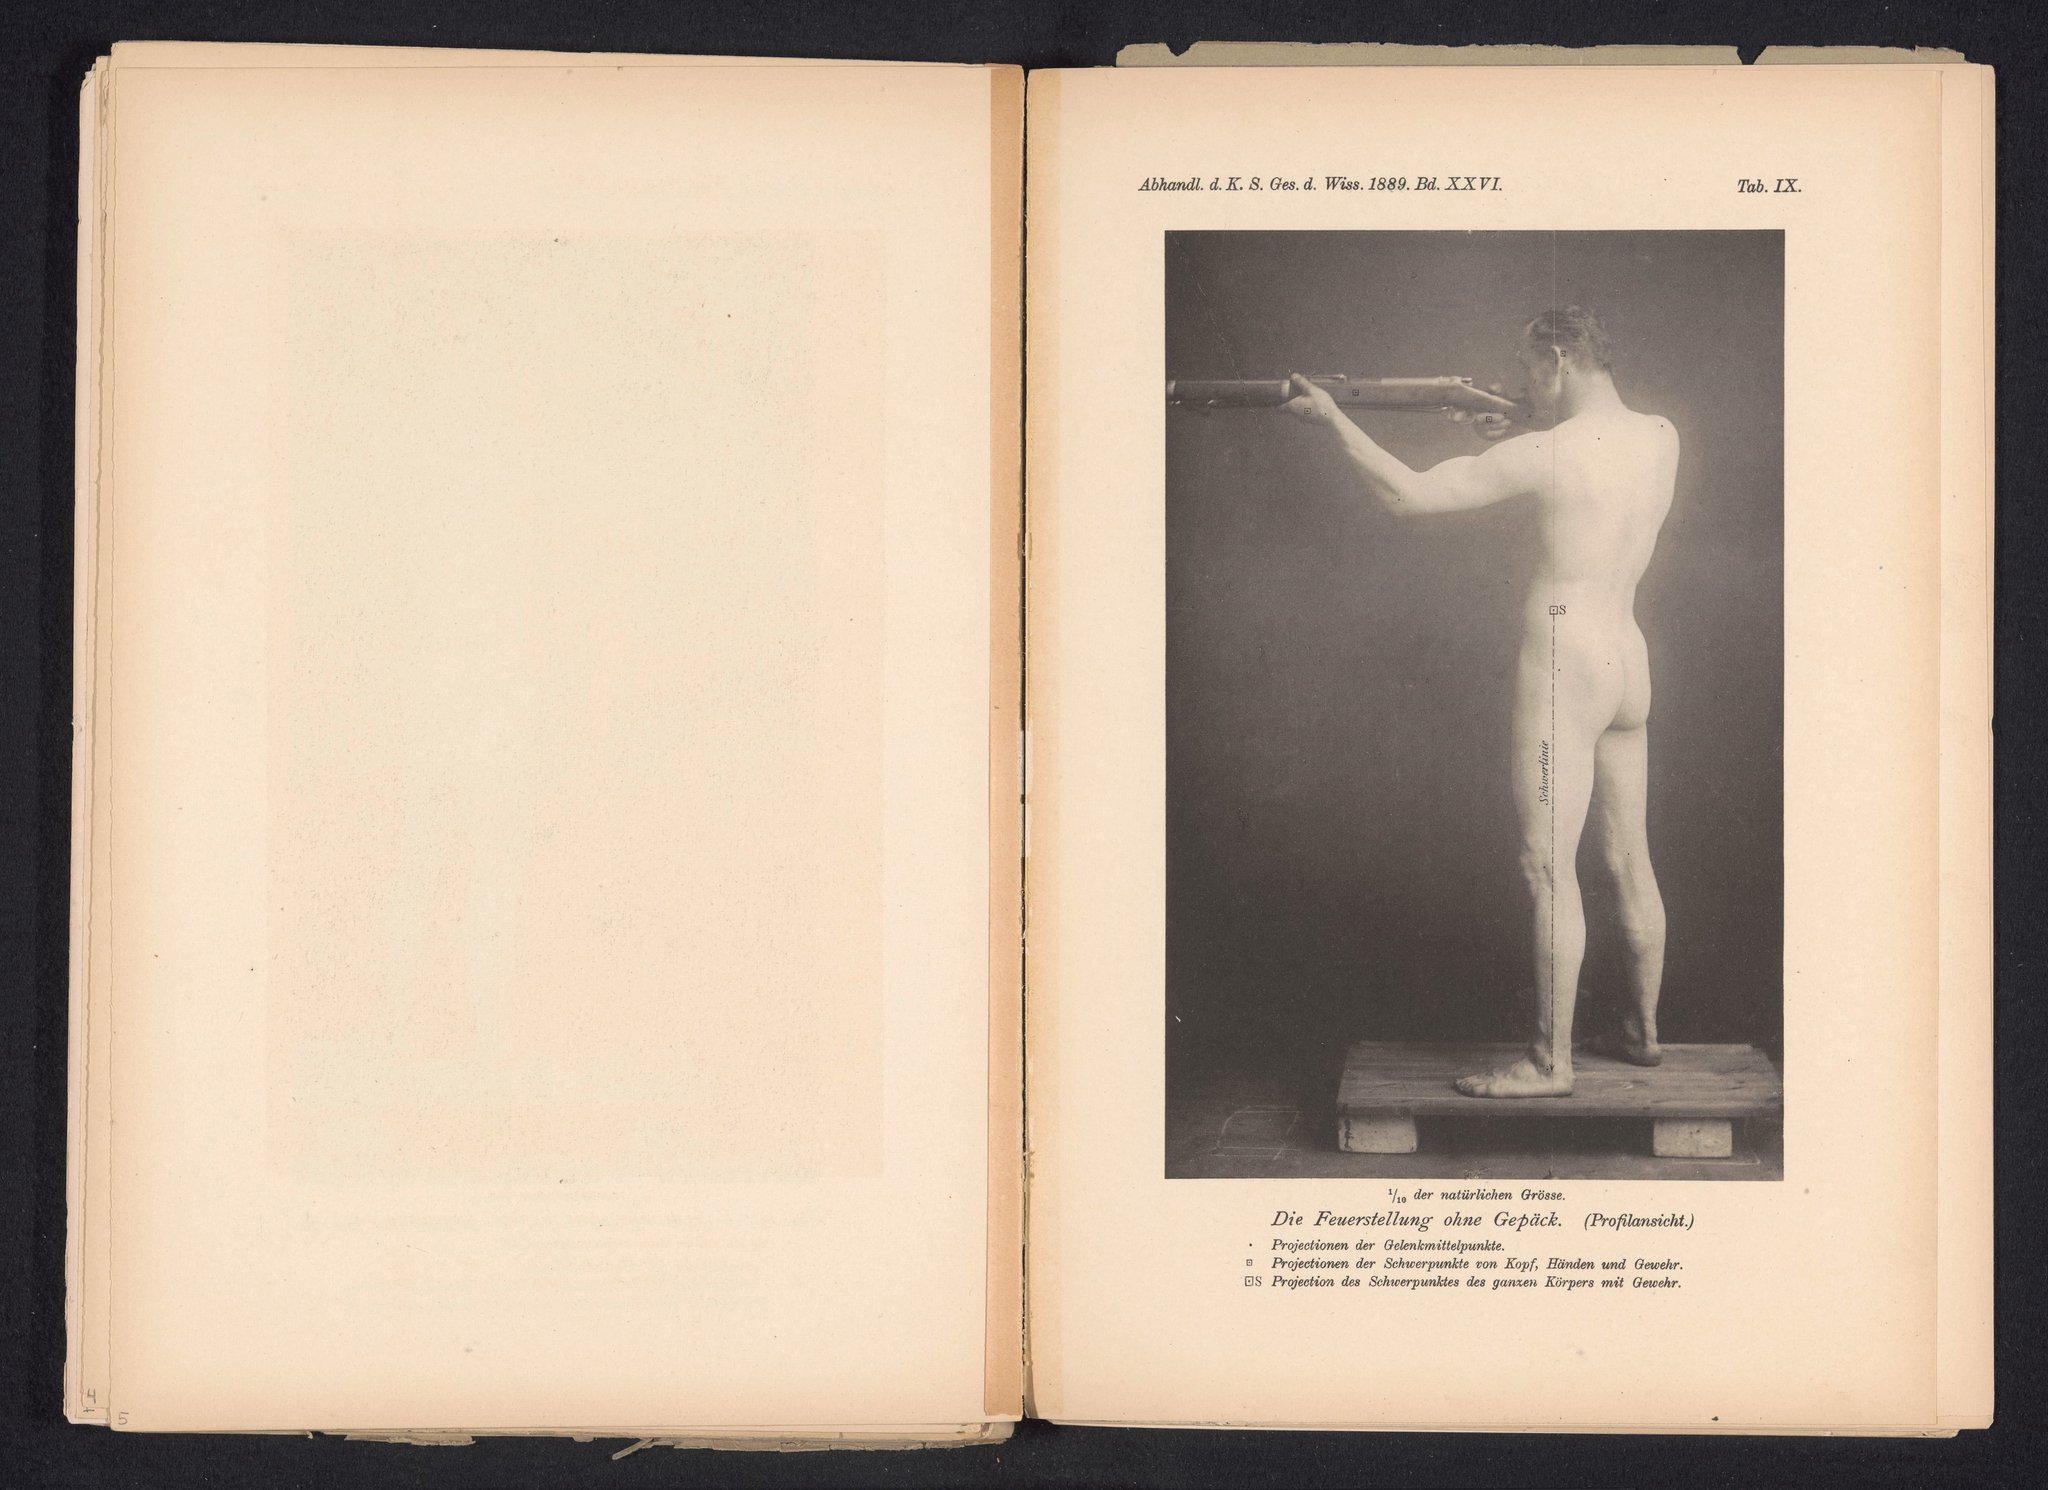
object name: photomechanical print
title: Onbekende naakte man, en profil met een geweer in een schiethouding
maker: Anonymous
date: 1880-1890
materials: paper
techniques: photograph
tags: anatomy (non-medical), firearms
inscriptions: inscription: ‘Schwerlinie. 1/10 der natürlichen Grösse. Projectionen der Gelenkmittelpunkte. Projectionen der Schwerpunkte von Kopf, Händen und Gewehr. Projection des Schwerpunkte des ganzen Körpers mit Gewehr.’, number: ‘Tab. IX.’